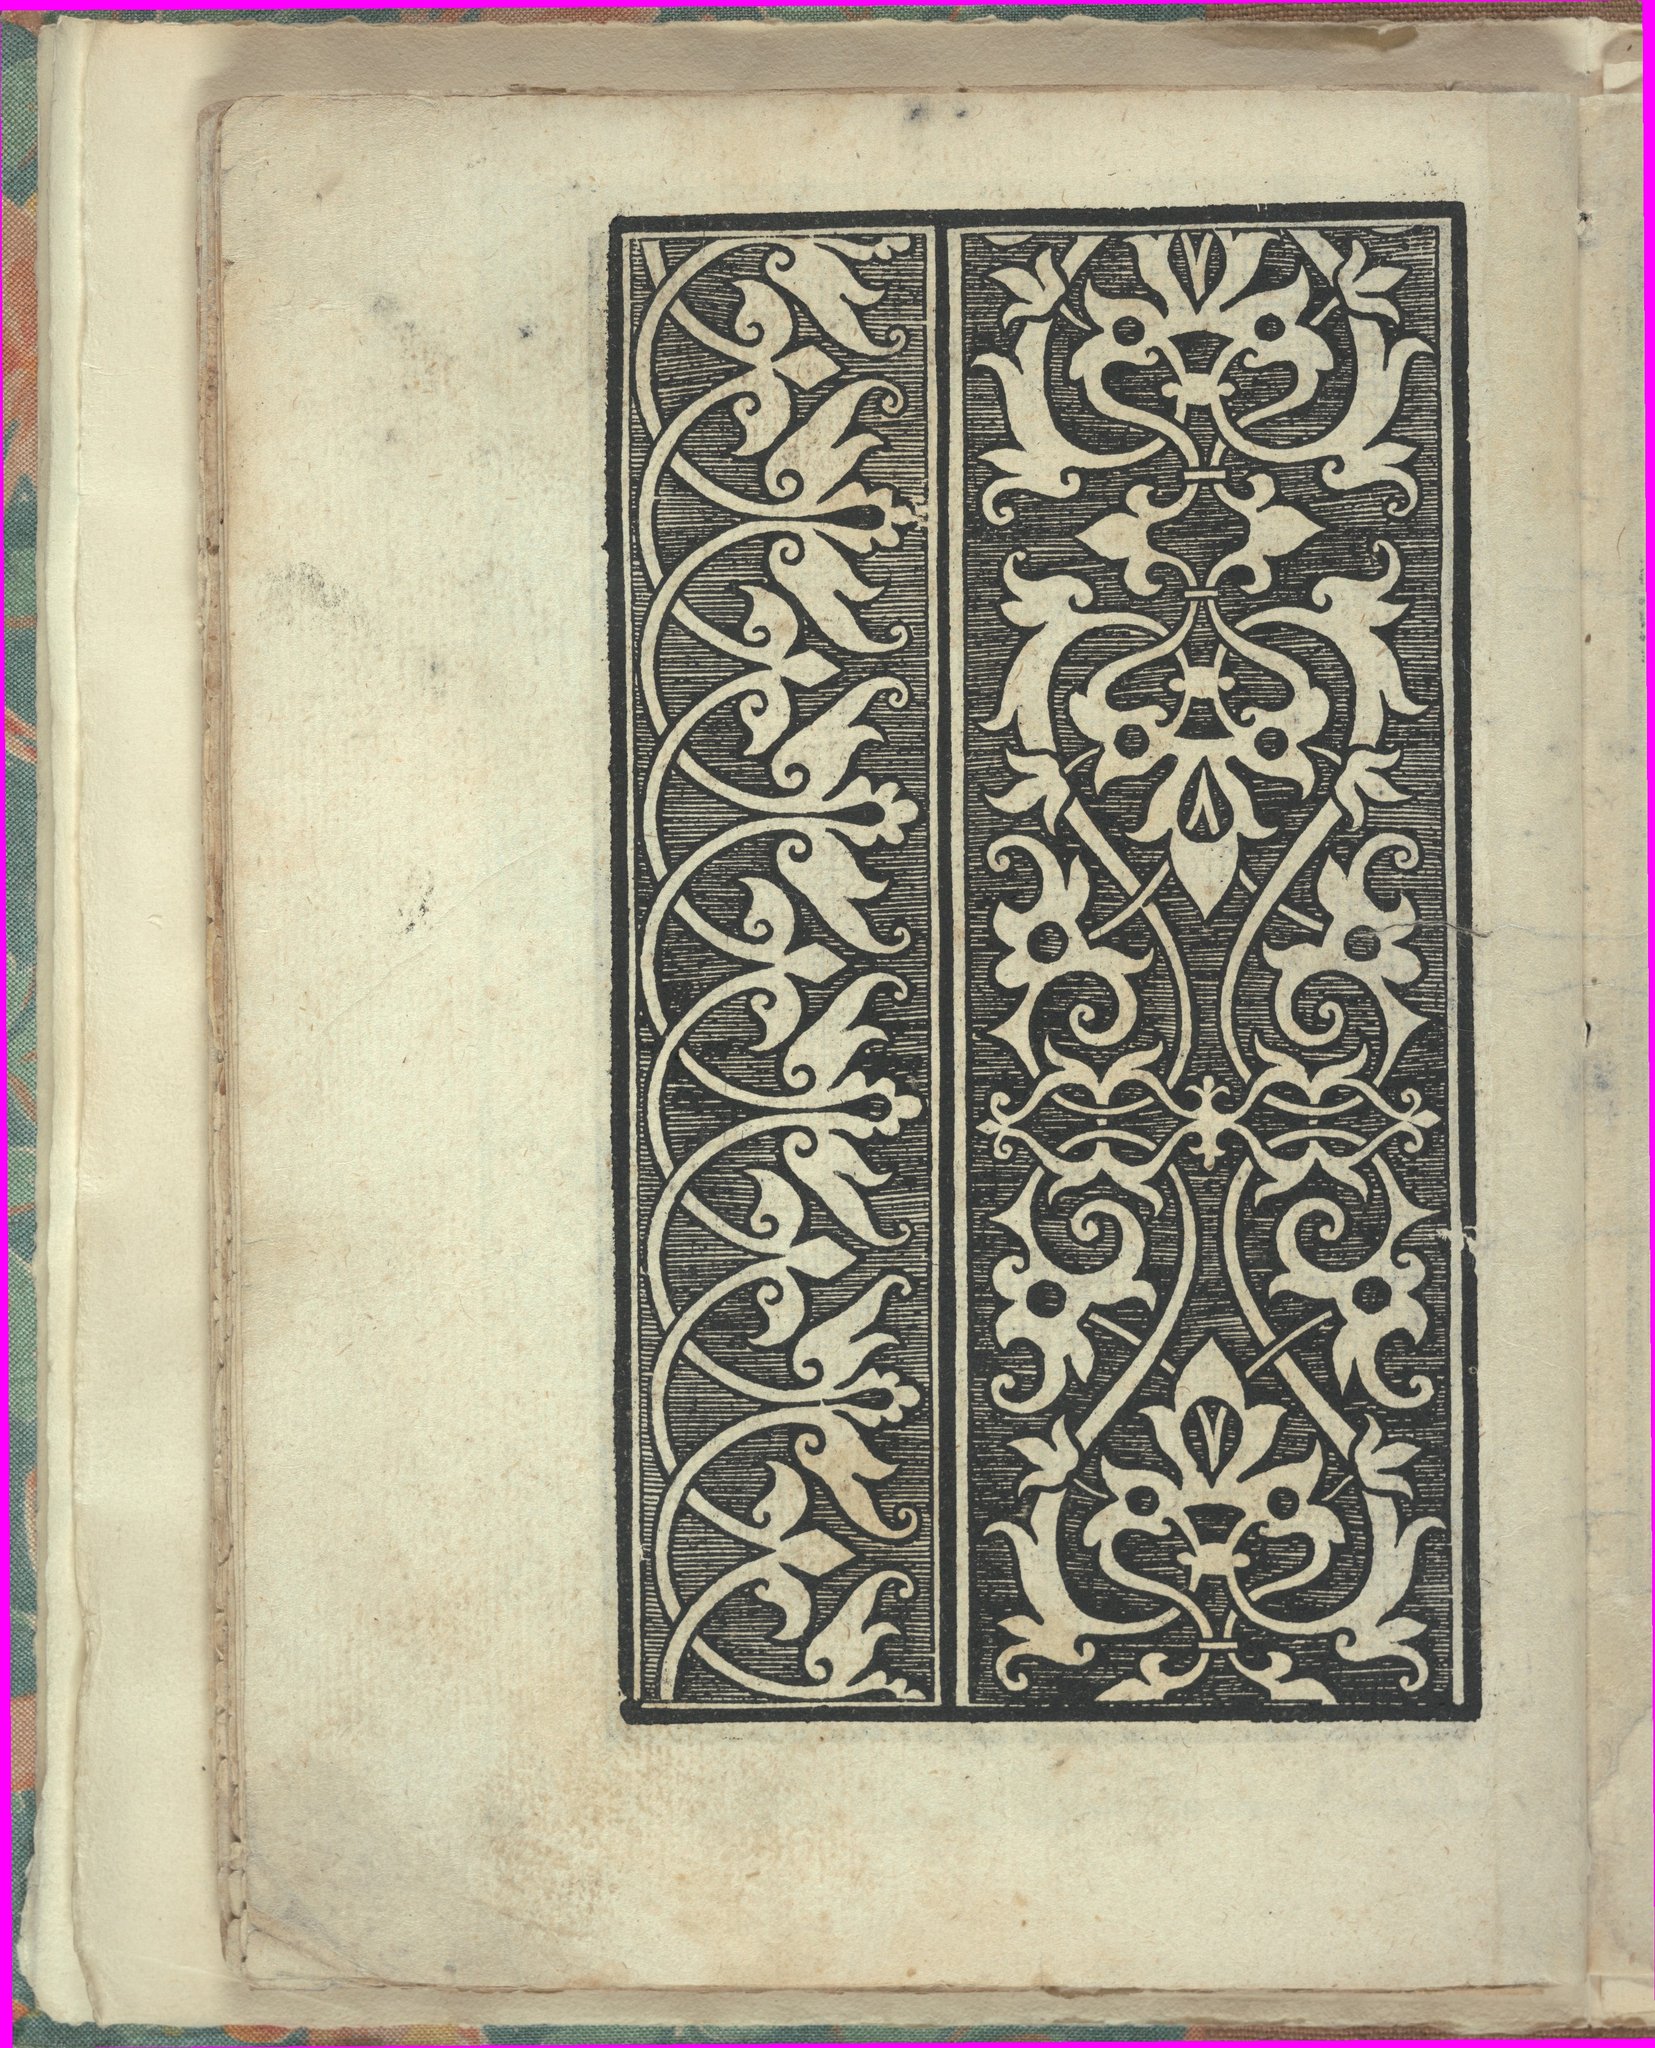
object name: book print ornament architecture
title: Opera Nova Universali intitulata Corona di racammi, page 36 (verso)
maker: giovanni andrea vavassore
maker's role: publisher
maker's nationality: italian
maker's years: 1530-1573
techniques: woodcut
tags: flowers